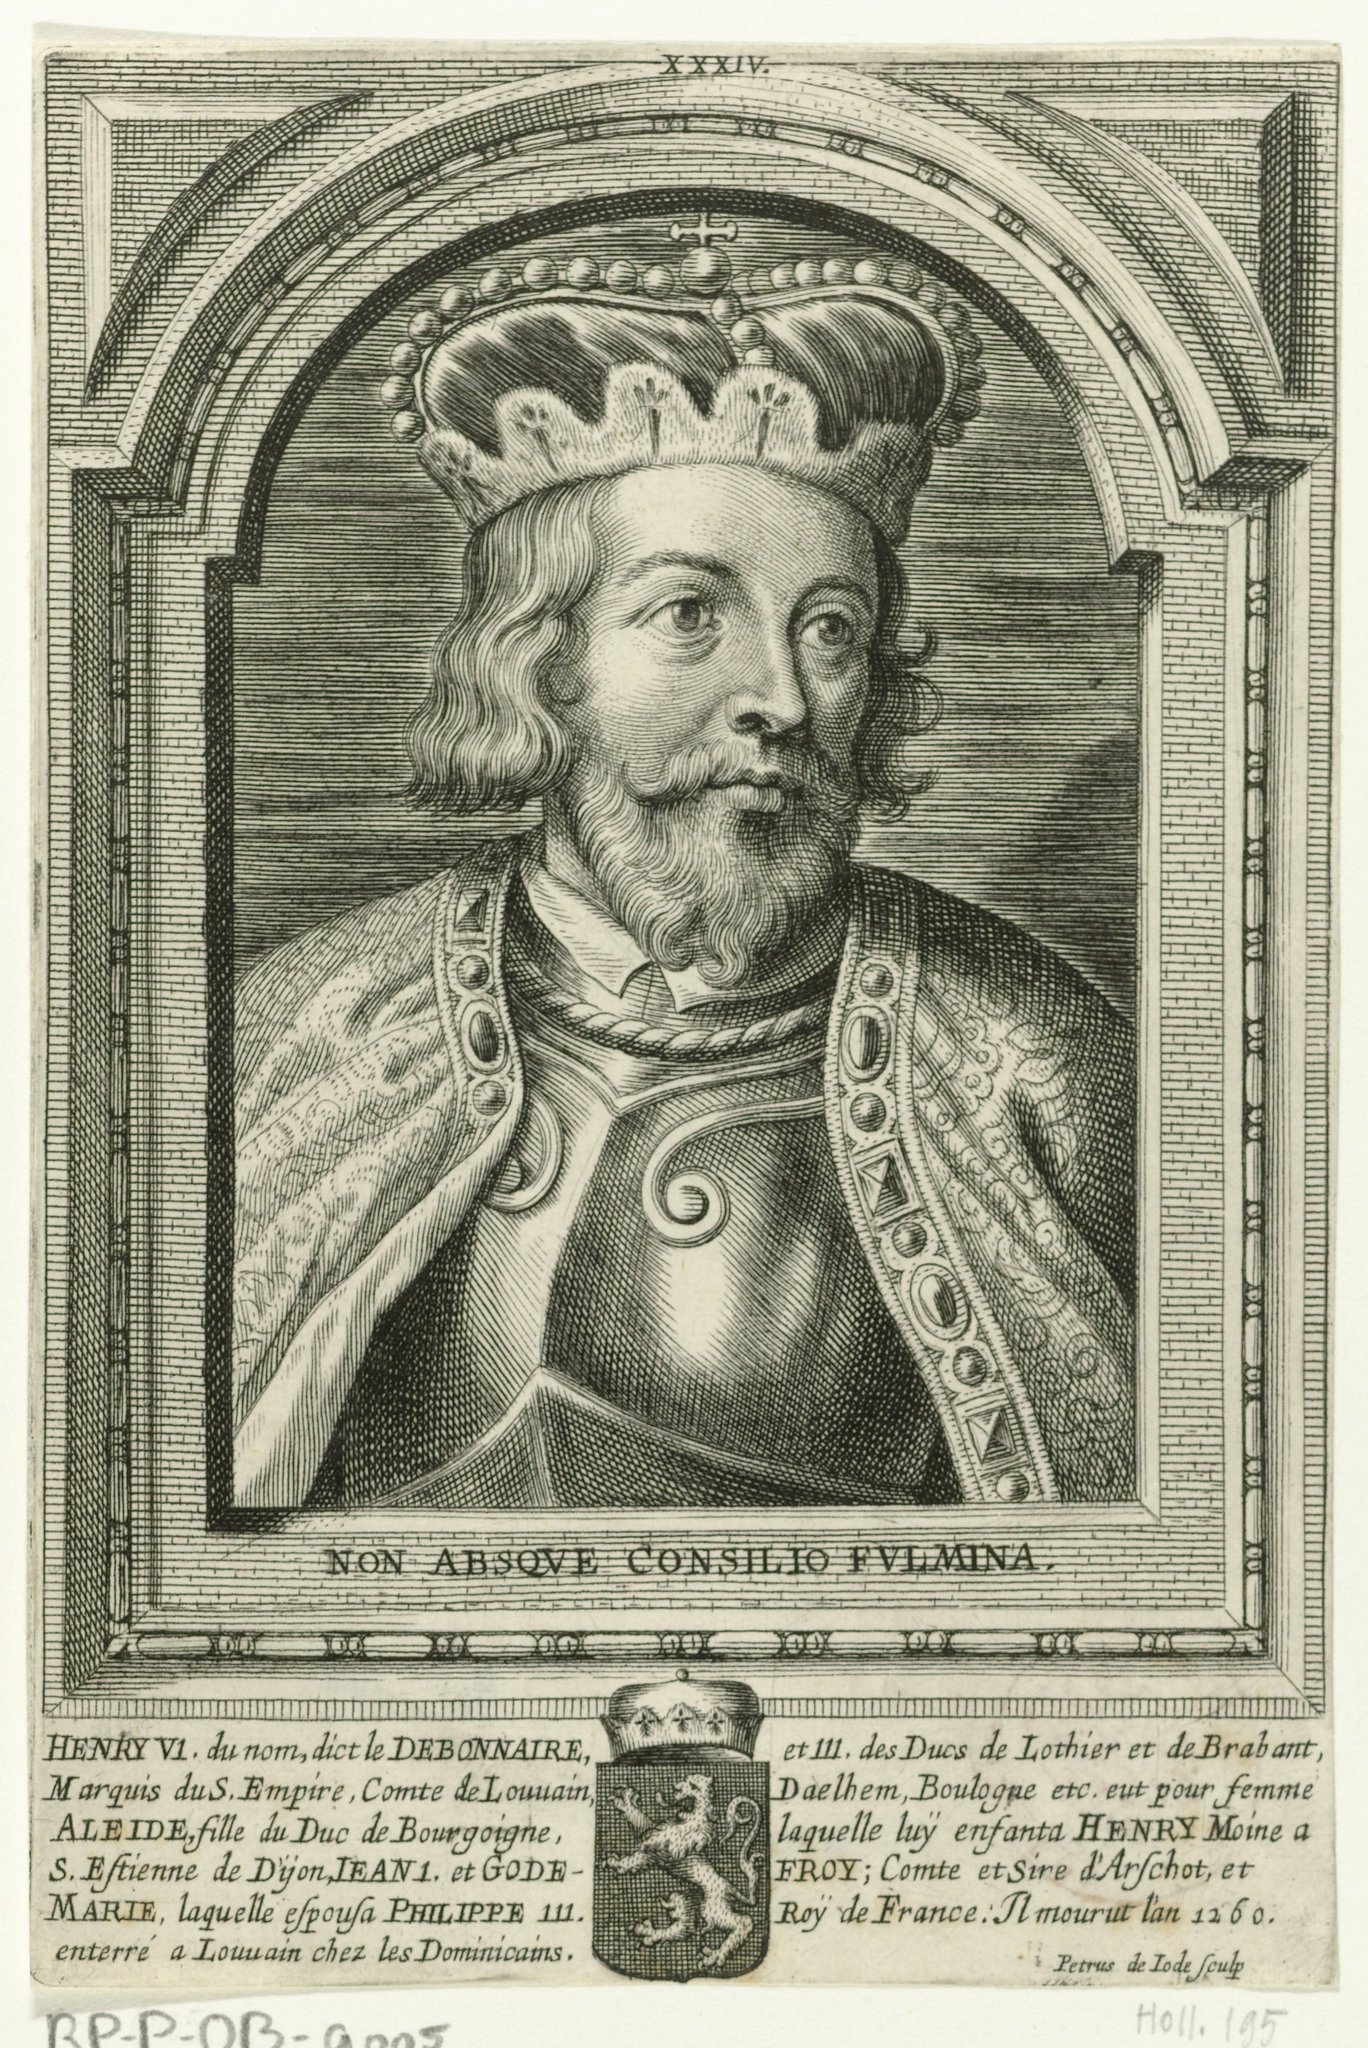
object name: book illustration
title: Portret van Hendrik VI de Vrome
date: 1661-1663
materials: paper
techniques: engraving, etching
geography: antwerp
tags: crown (symbol of sovereignty)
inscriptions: collector's mark: Lugt 240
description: Busteportret van Hendrik VI de Vrome, met kroon. Het portret is gevat in een boogvormige omlijsting met vierkant randwerk en een motto in het Latijn. In de marge het wapenschild van de geportretteerde en een zesregelig onderschrift in het Frans. Prent uit een boek waarin 54 prenten met portretten.